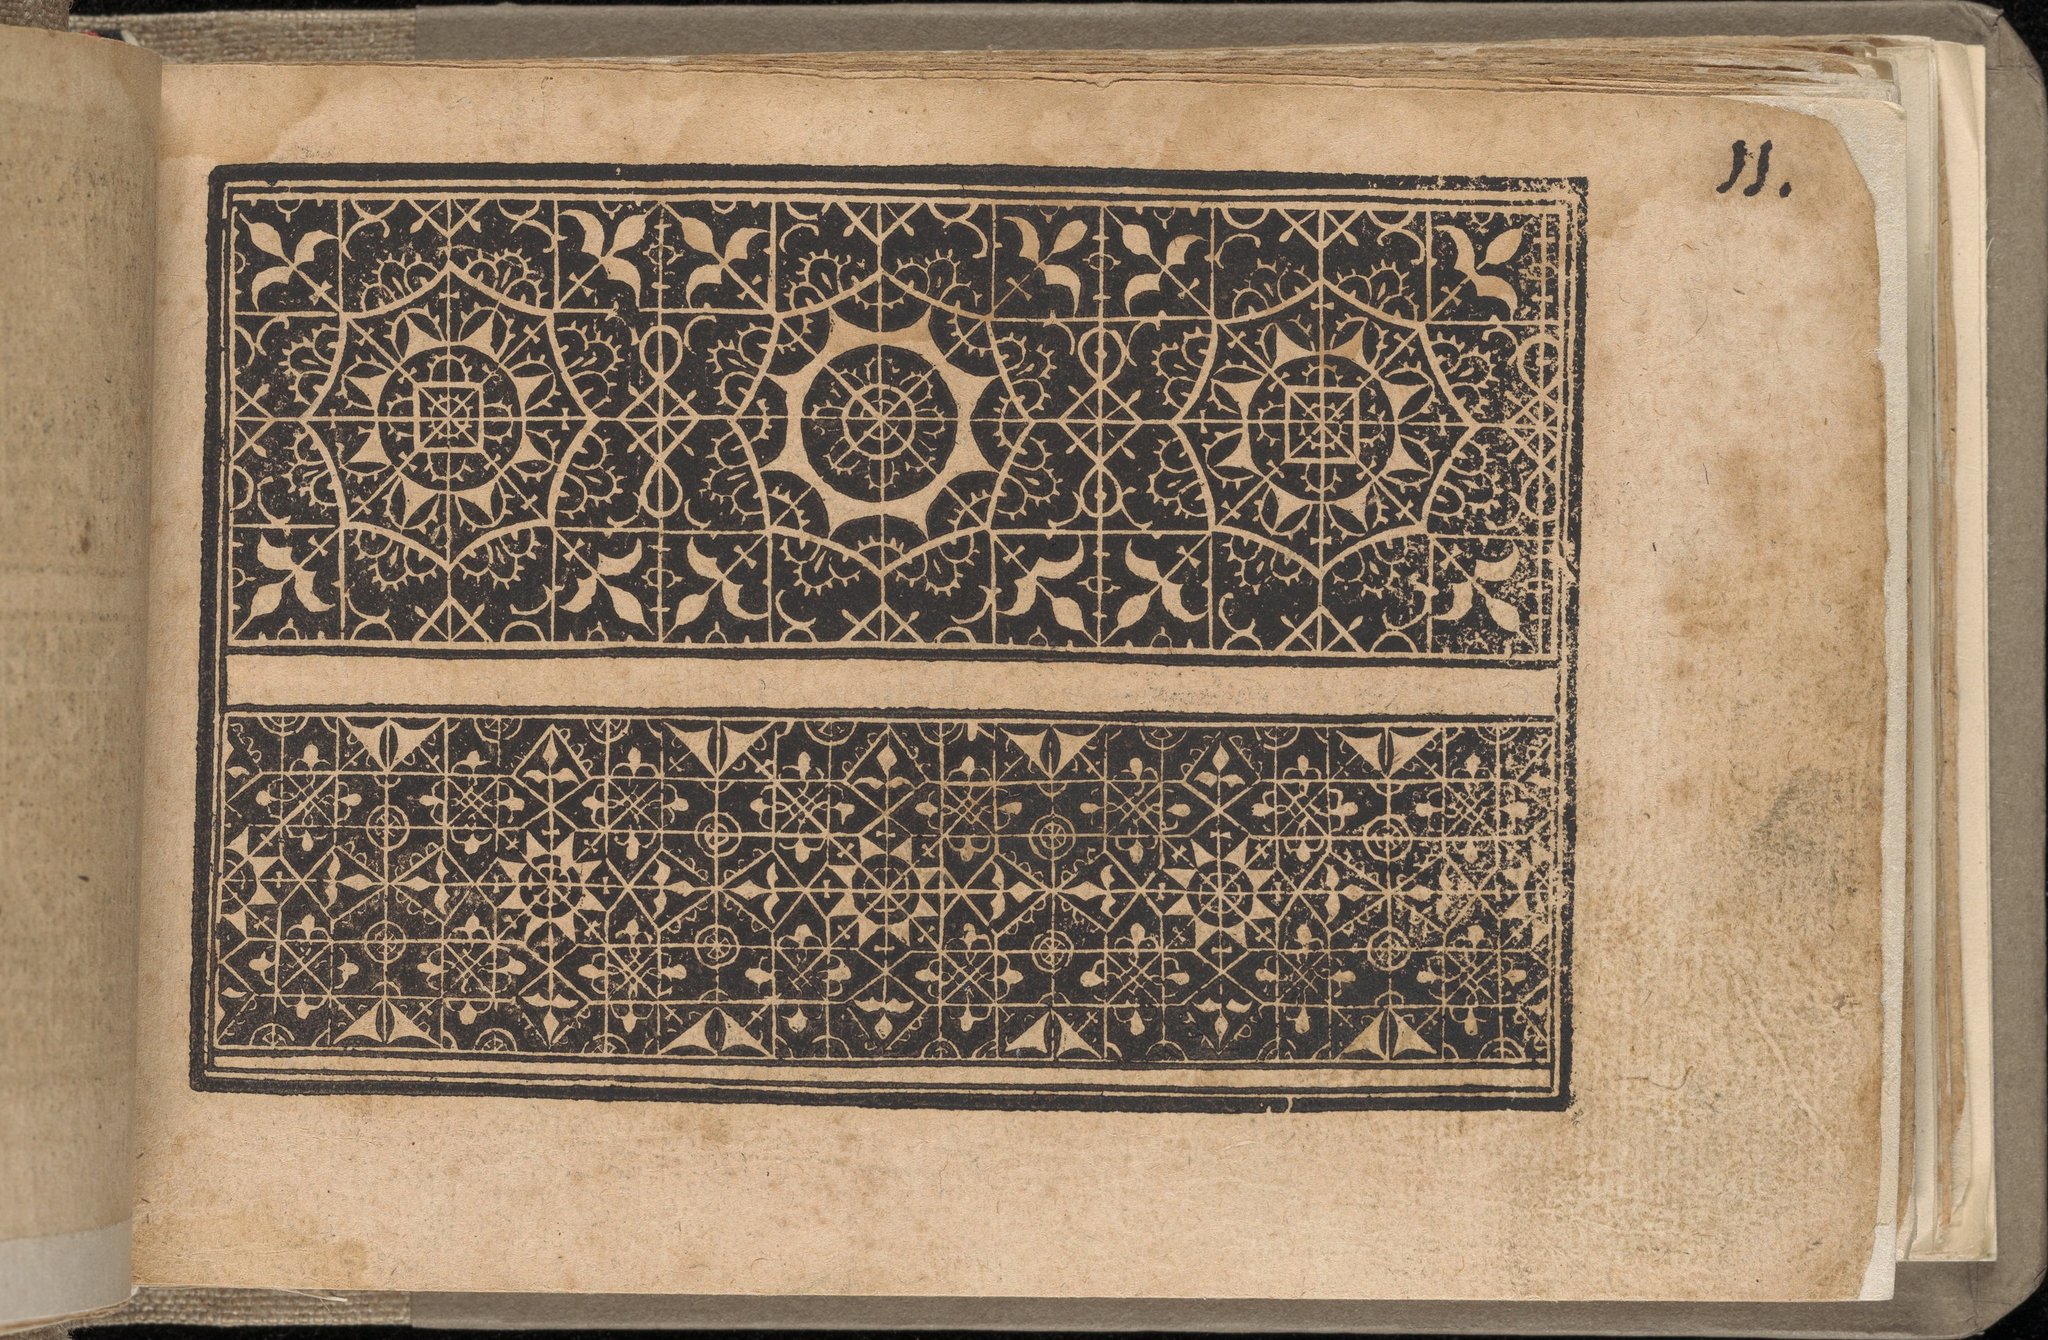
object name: book print ornament architecture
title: Schön newes Modelbuch (Page 11r)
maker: sigismundus latomus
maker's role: publisher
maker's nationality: german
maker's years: 1599-1632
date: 1608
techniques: woodcut